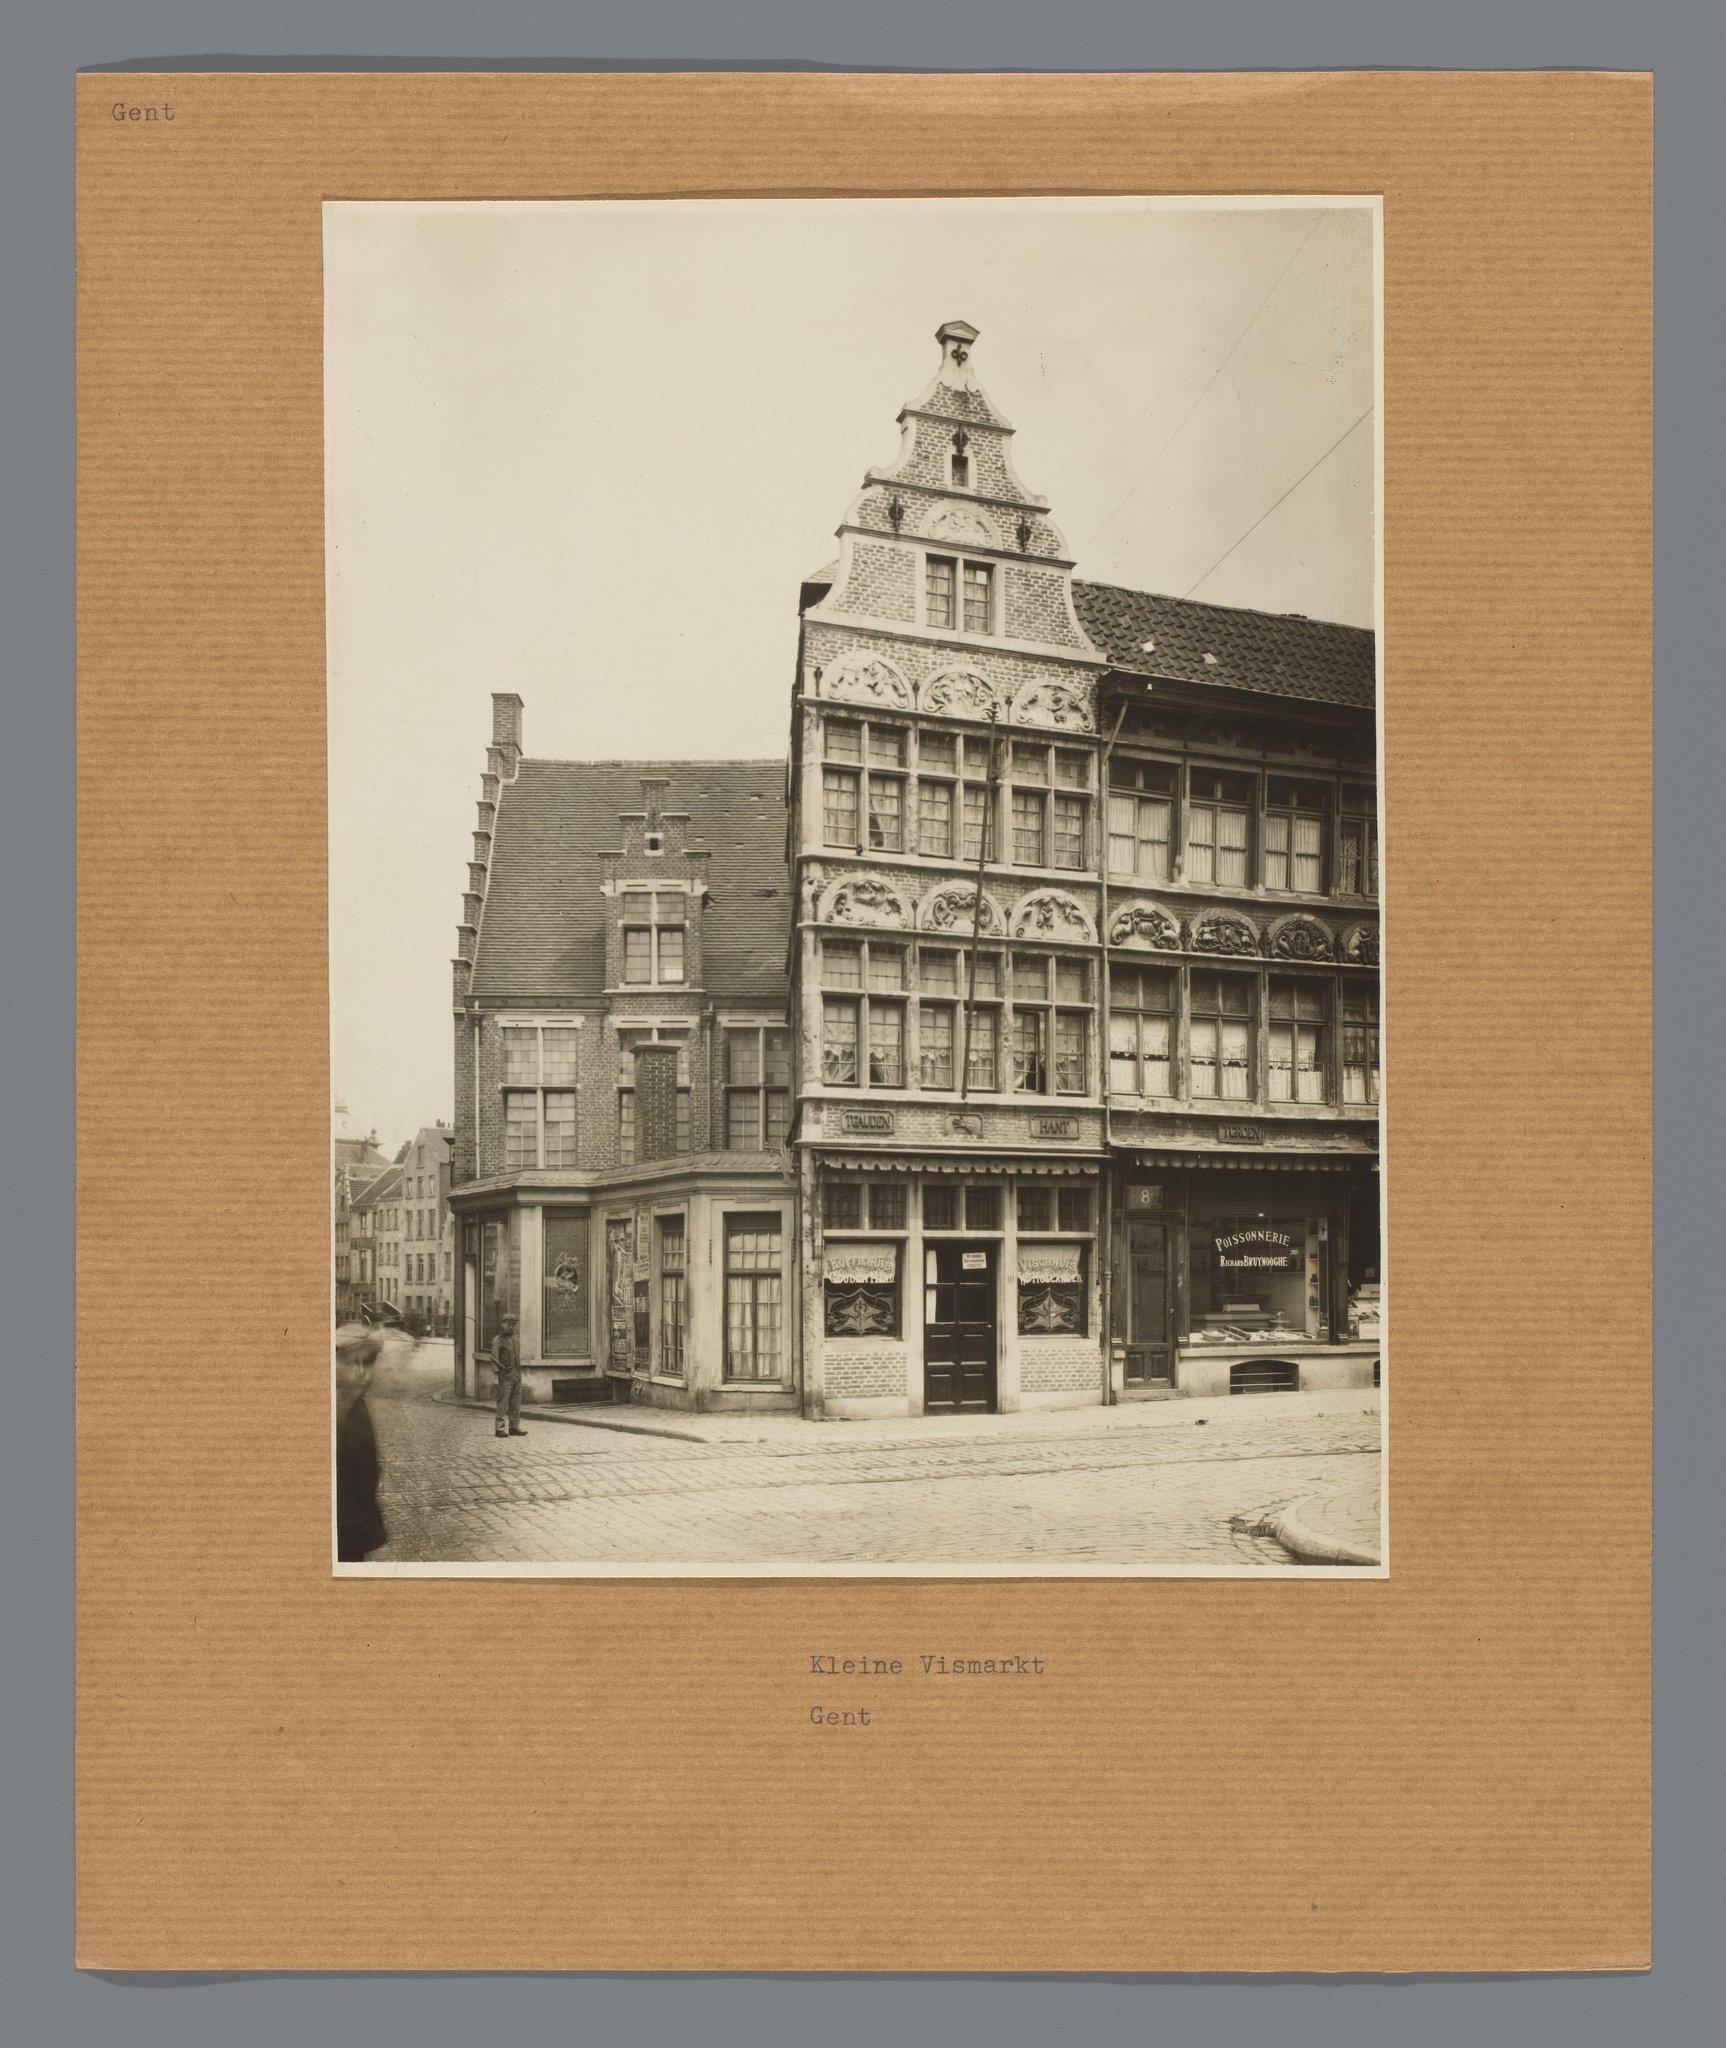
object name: photograph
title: Gent. Kleine Vismarkt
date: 1880-1930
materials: photographic support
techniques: gelatin silver print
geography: darmstadt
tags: ghent